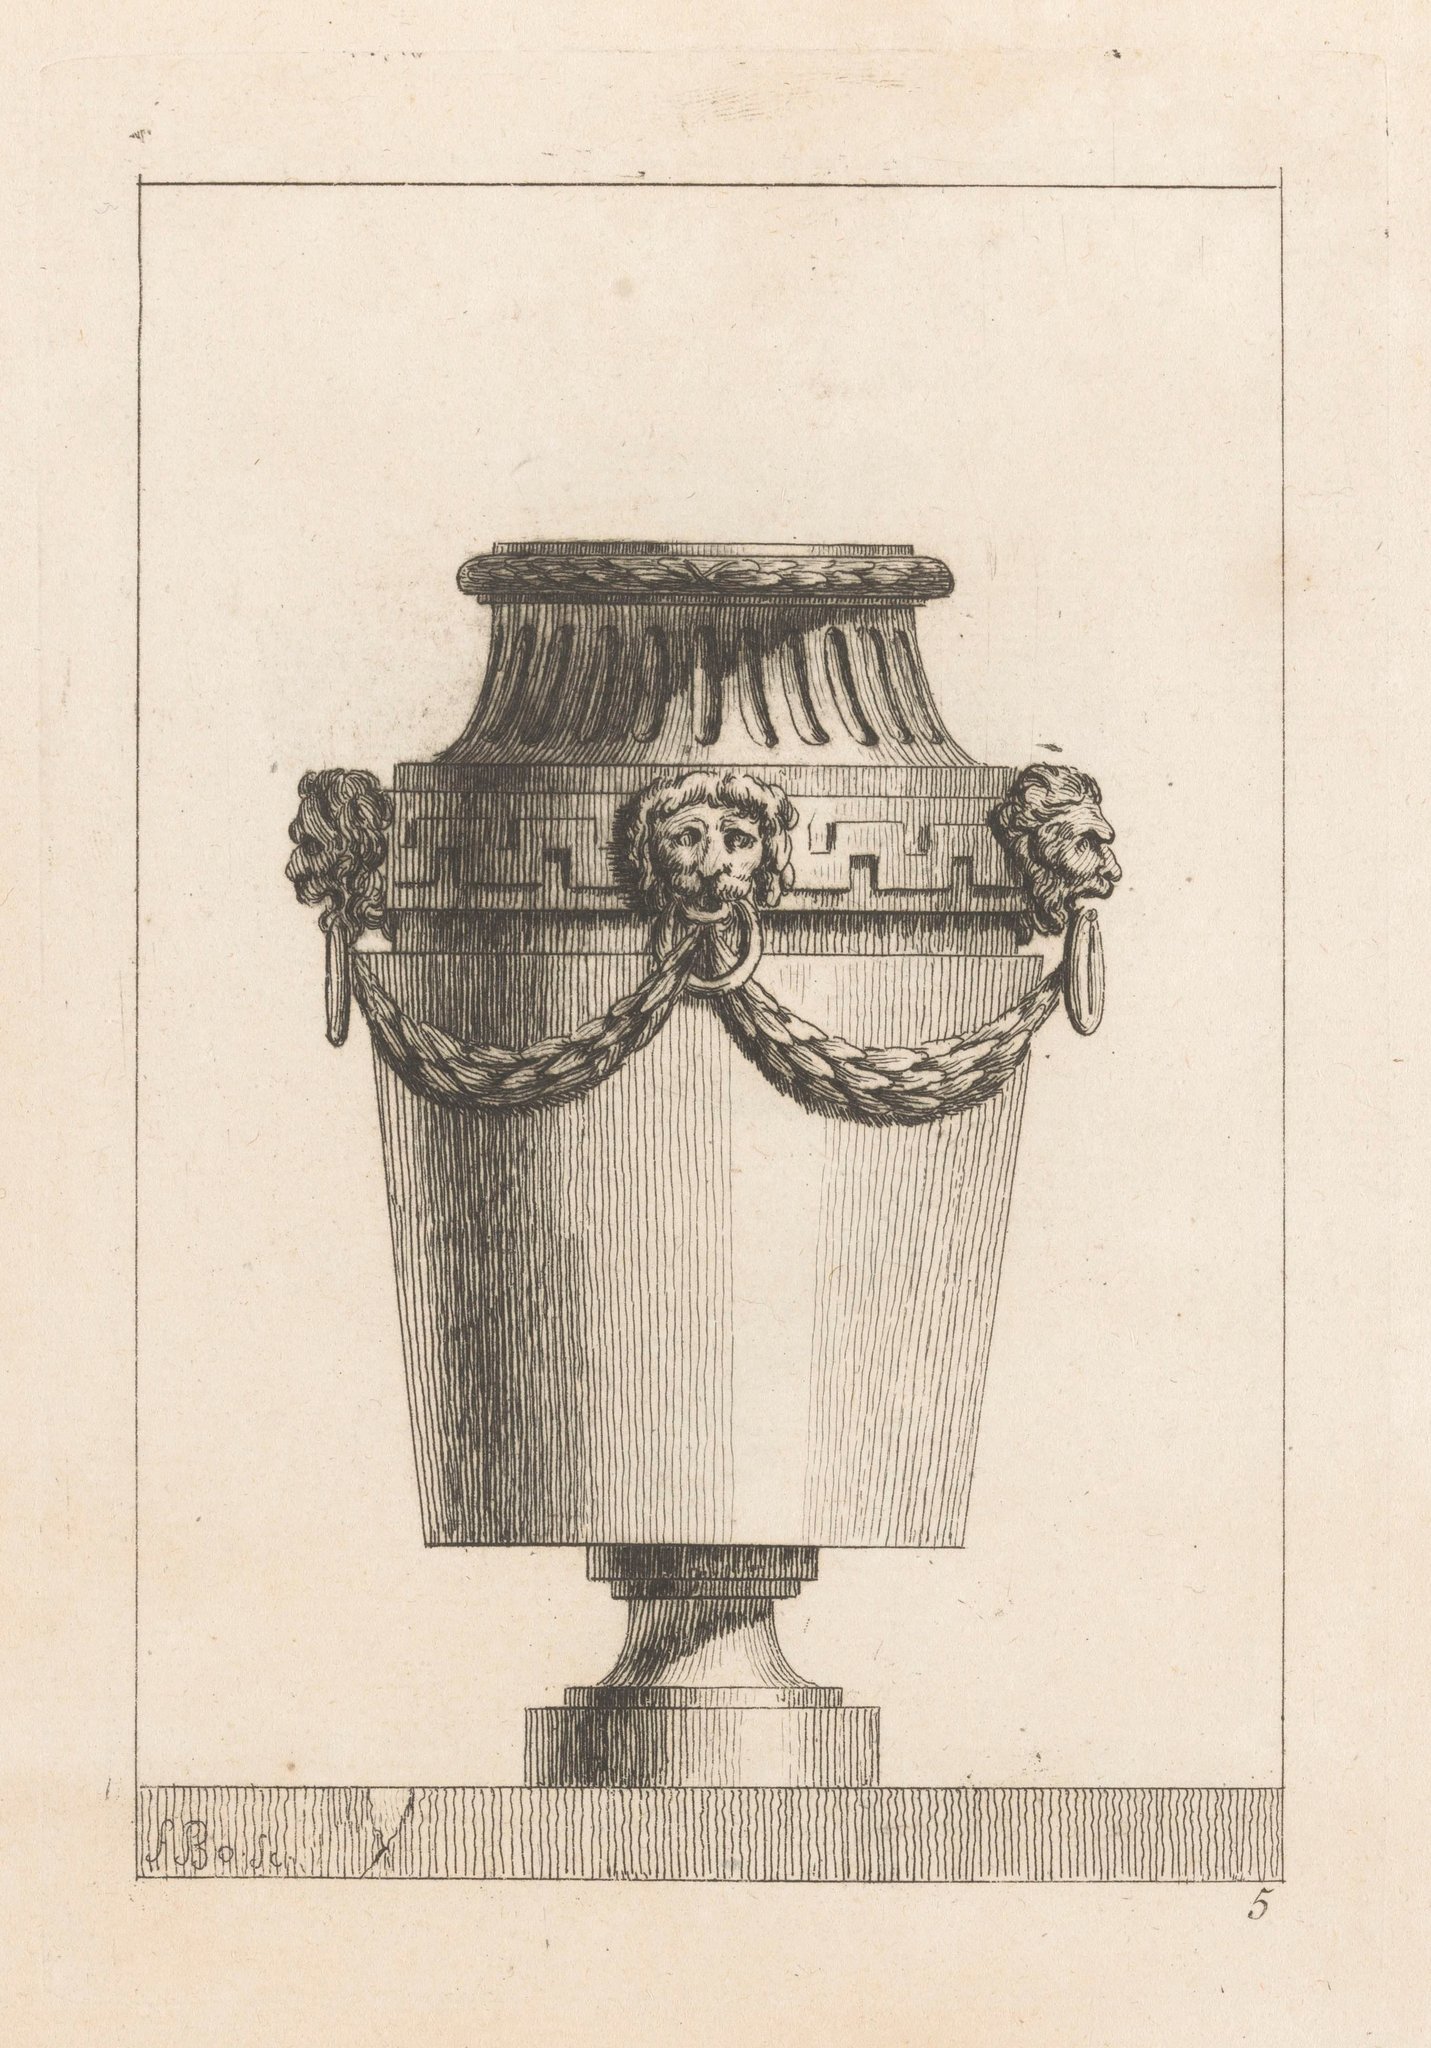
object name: ornament print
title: Nouveau Livre de Vases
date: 1755-1782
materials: paper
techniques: etching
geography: paris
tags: lion's head ~ ornament, vase ~ ornament, ornament ~ festoon, garland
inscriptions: collector's mark: Lugt 2228, collector's mark: Lugt 2760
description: Een vaas met guirlande en leeuwenkoppen.